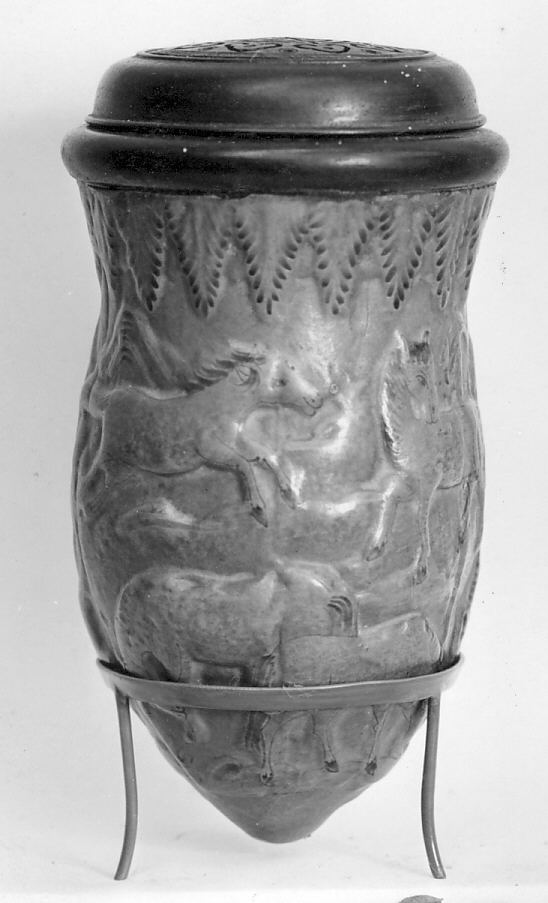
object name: cricket cage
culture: chinese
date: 1601-1900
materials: wood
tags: horses